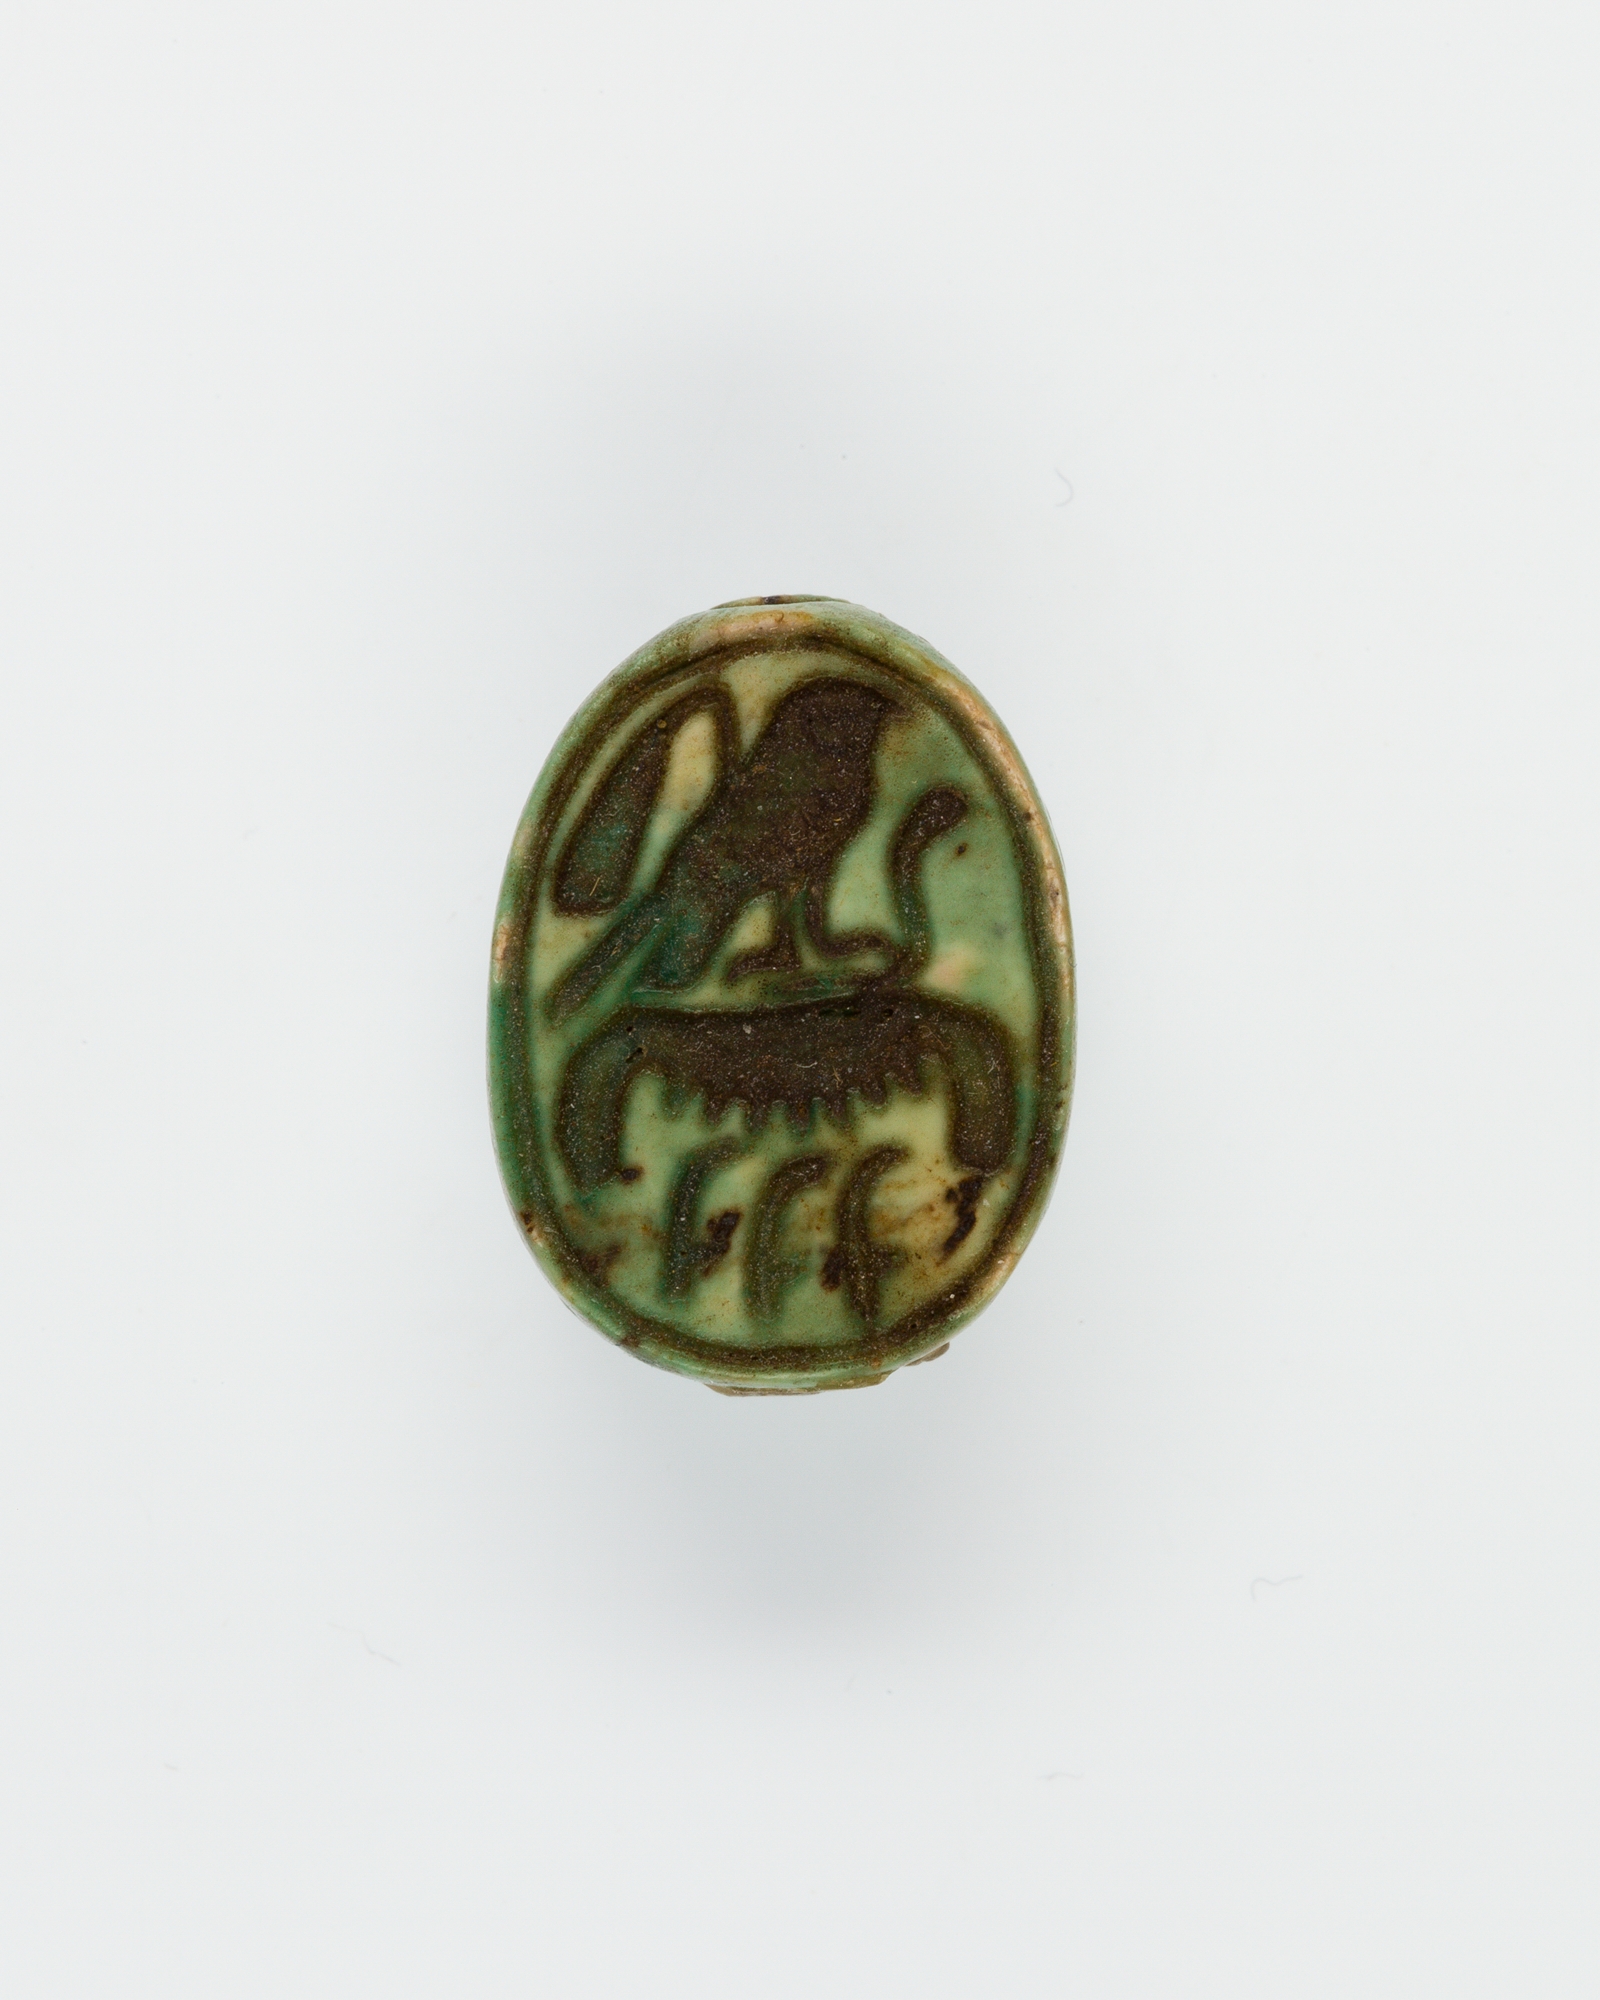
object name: scarab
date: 1492-1479 BCE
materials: stone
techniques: glazing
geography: egypt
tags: hieroglyphs,scarabs